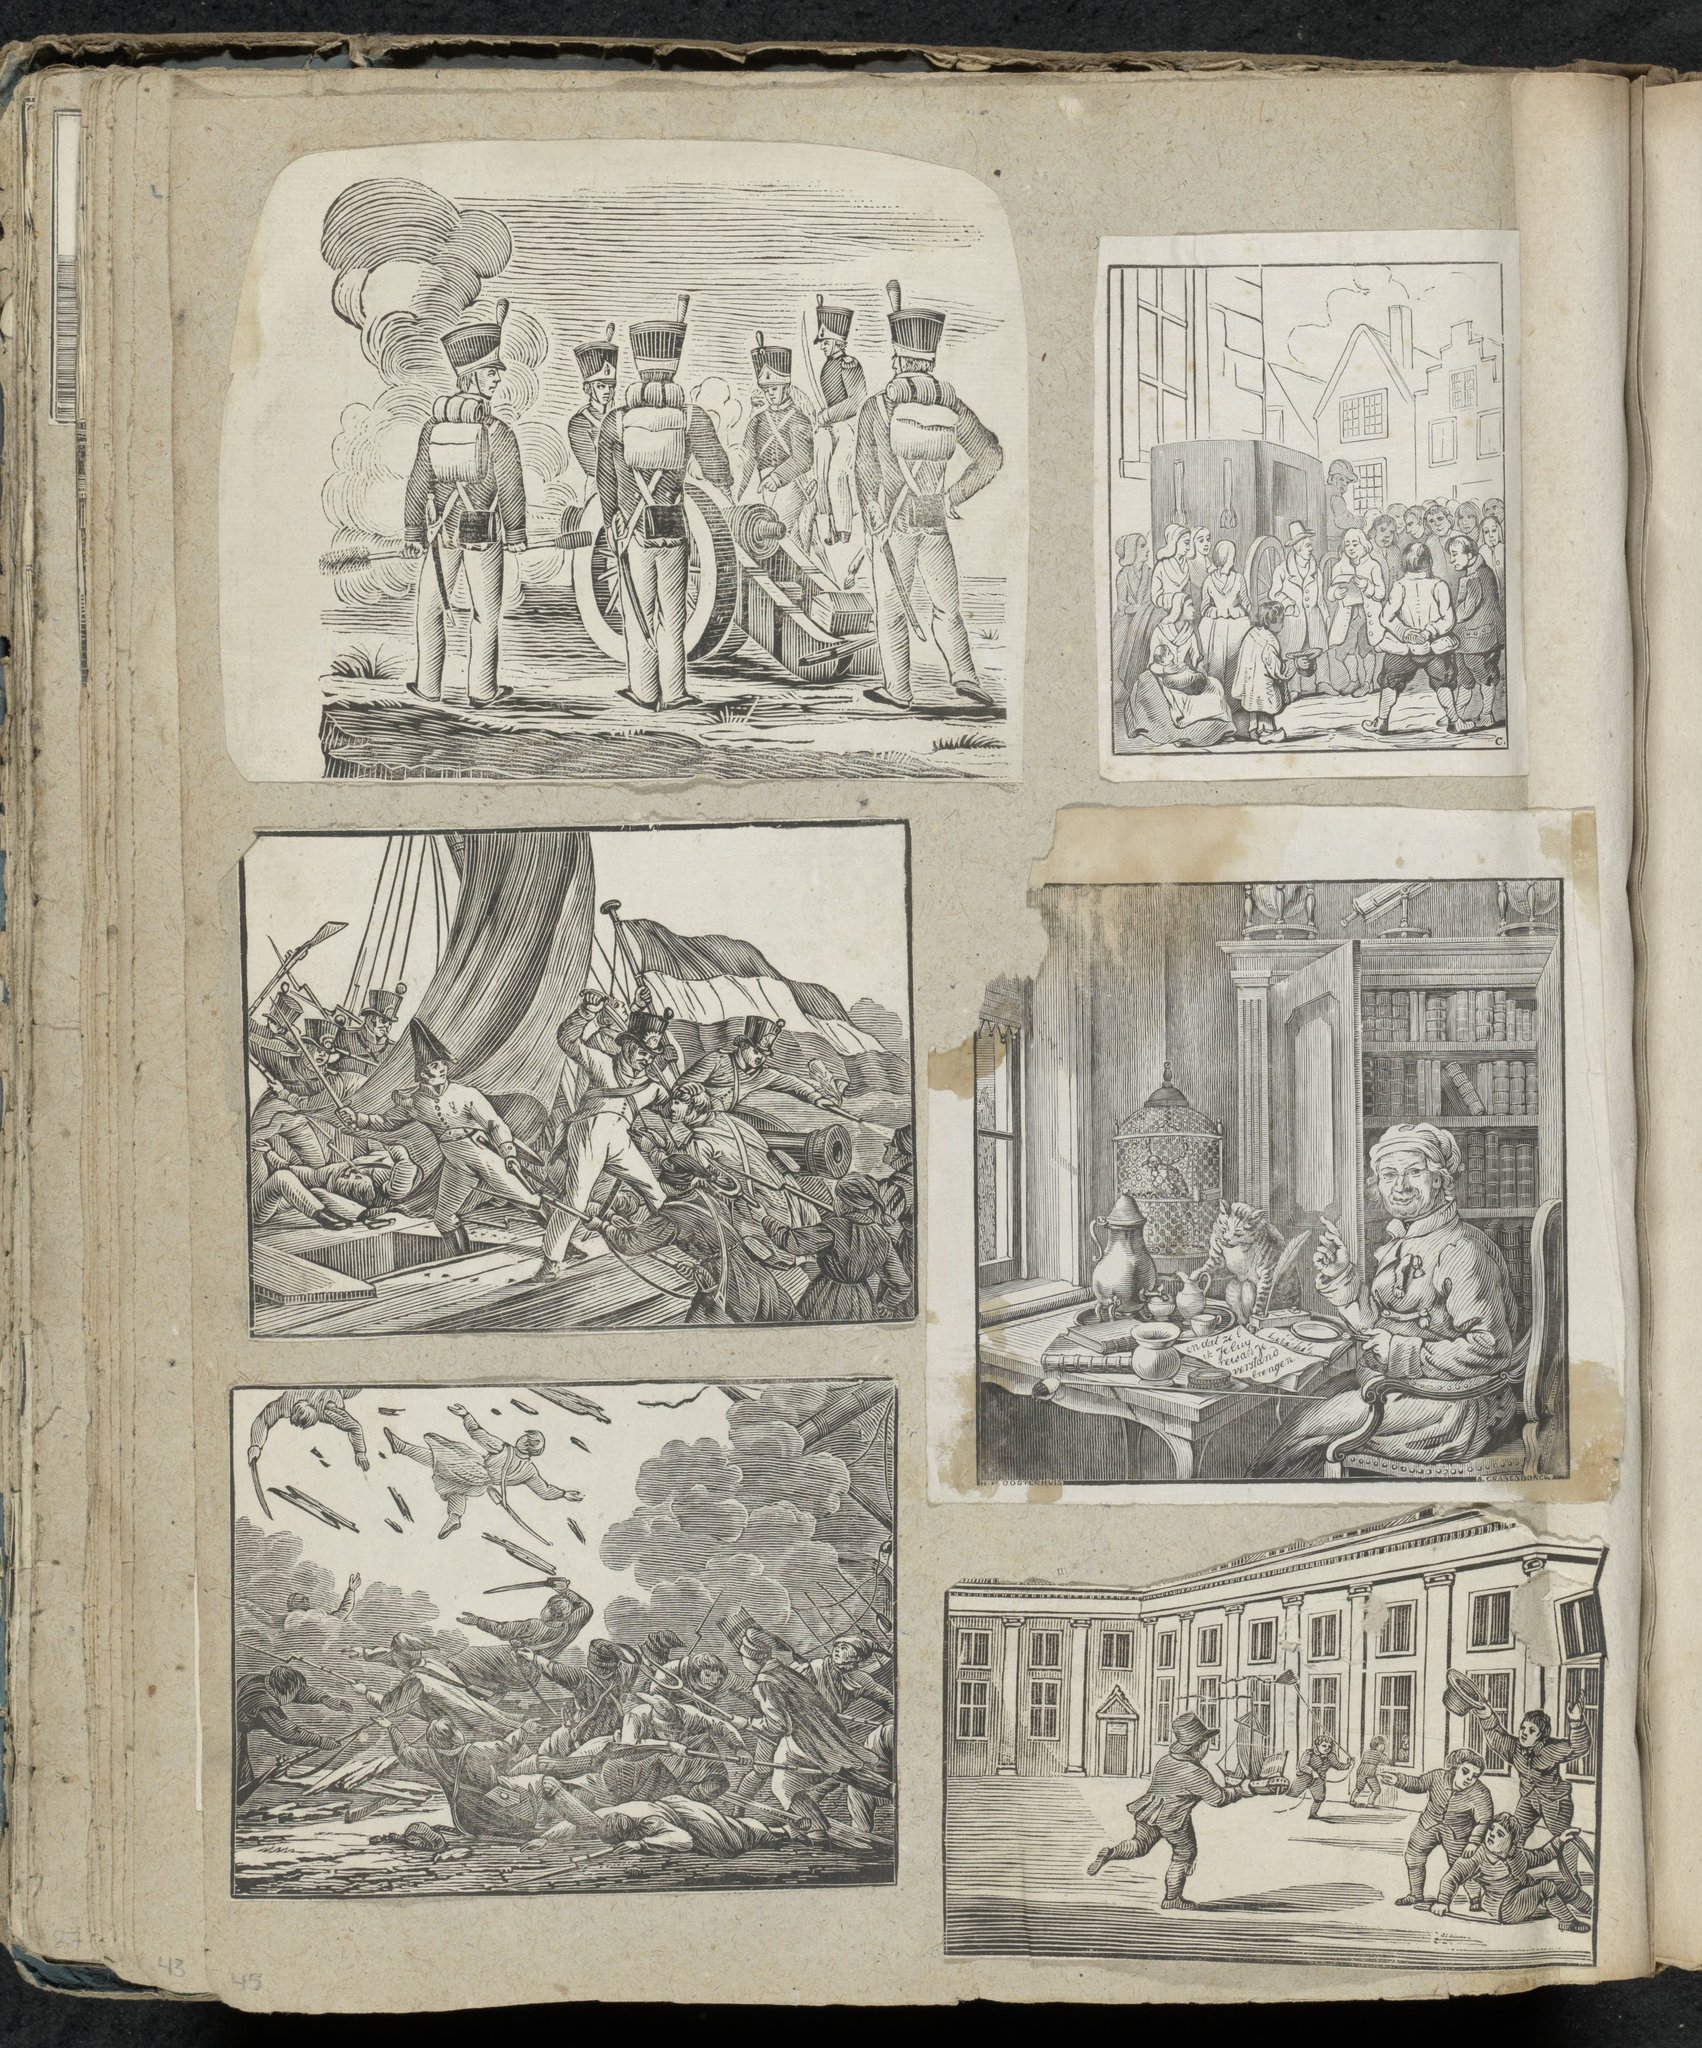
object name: album leaf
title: Albumblad met diverse voorstellingen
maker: alexander cranendoncq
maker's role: draughtsman, print maker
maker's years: 1799-1869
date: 1814-1869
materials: paper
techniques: snipping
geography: nijmegen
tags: crowd, mob, scholar in his study, children's games and plays, firearms: cannon (+ handling of weapons), battle, the soldier; the soldier's life, (flying a) kite, games using special objects (marbles, top, hoop, etc.)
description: Albumblad met 6 uitgeknipte voorstellingen uit voornamelijk volksprenten, van onder andere soldaten die een kanon afvuren, een menigte op straat, een geleerde in zijn studeerkamer en spelende kinderen.